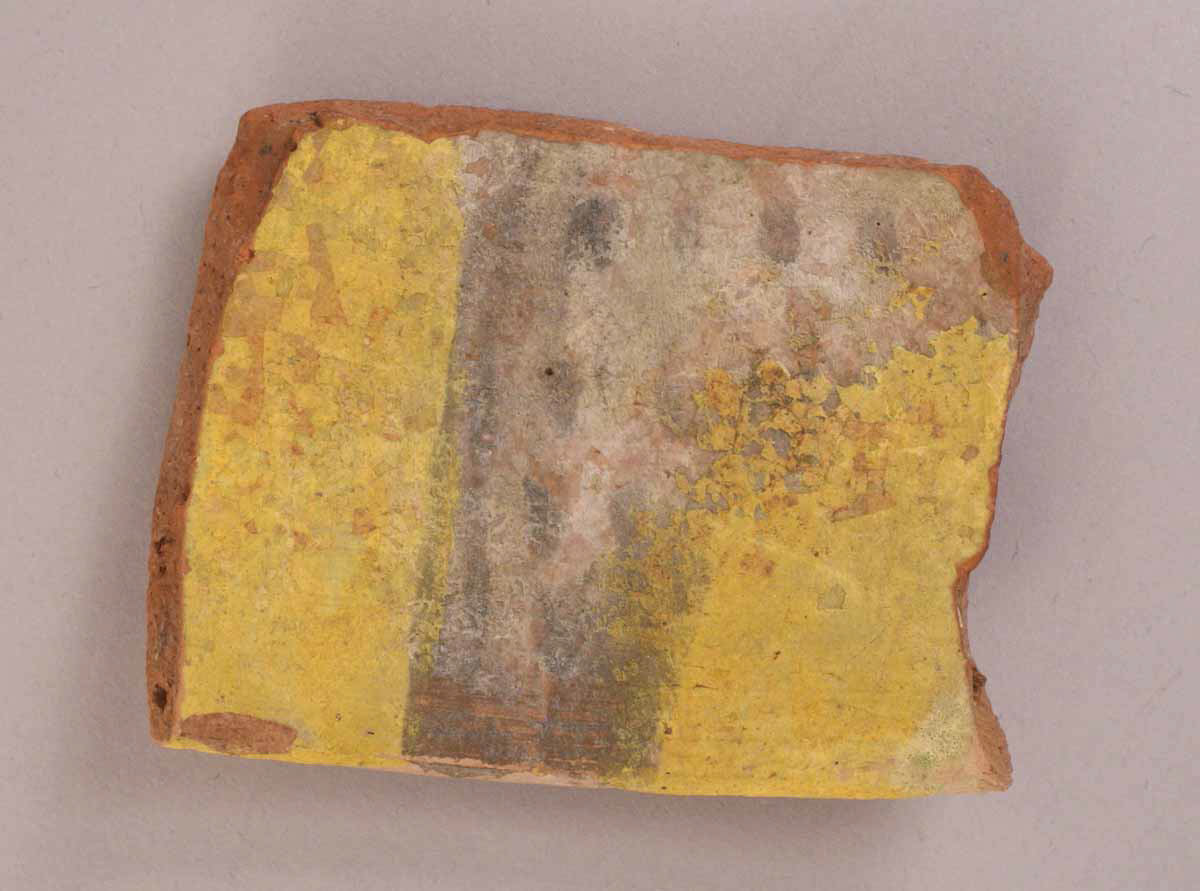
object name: fragment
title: Ceramic Fragment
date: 701-900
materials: earthenware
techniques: glazing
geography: iraq